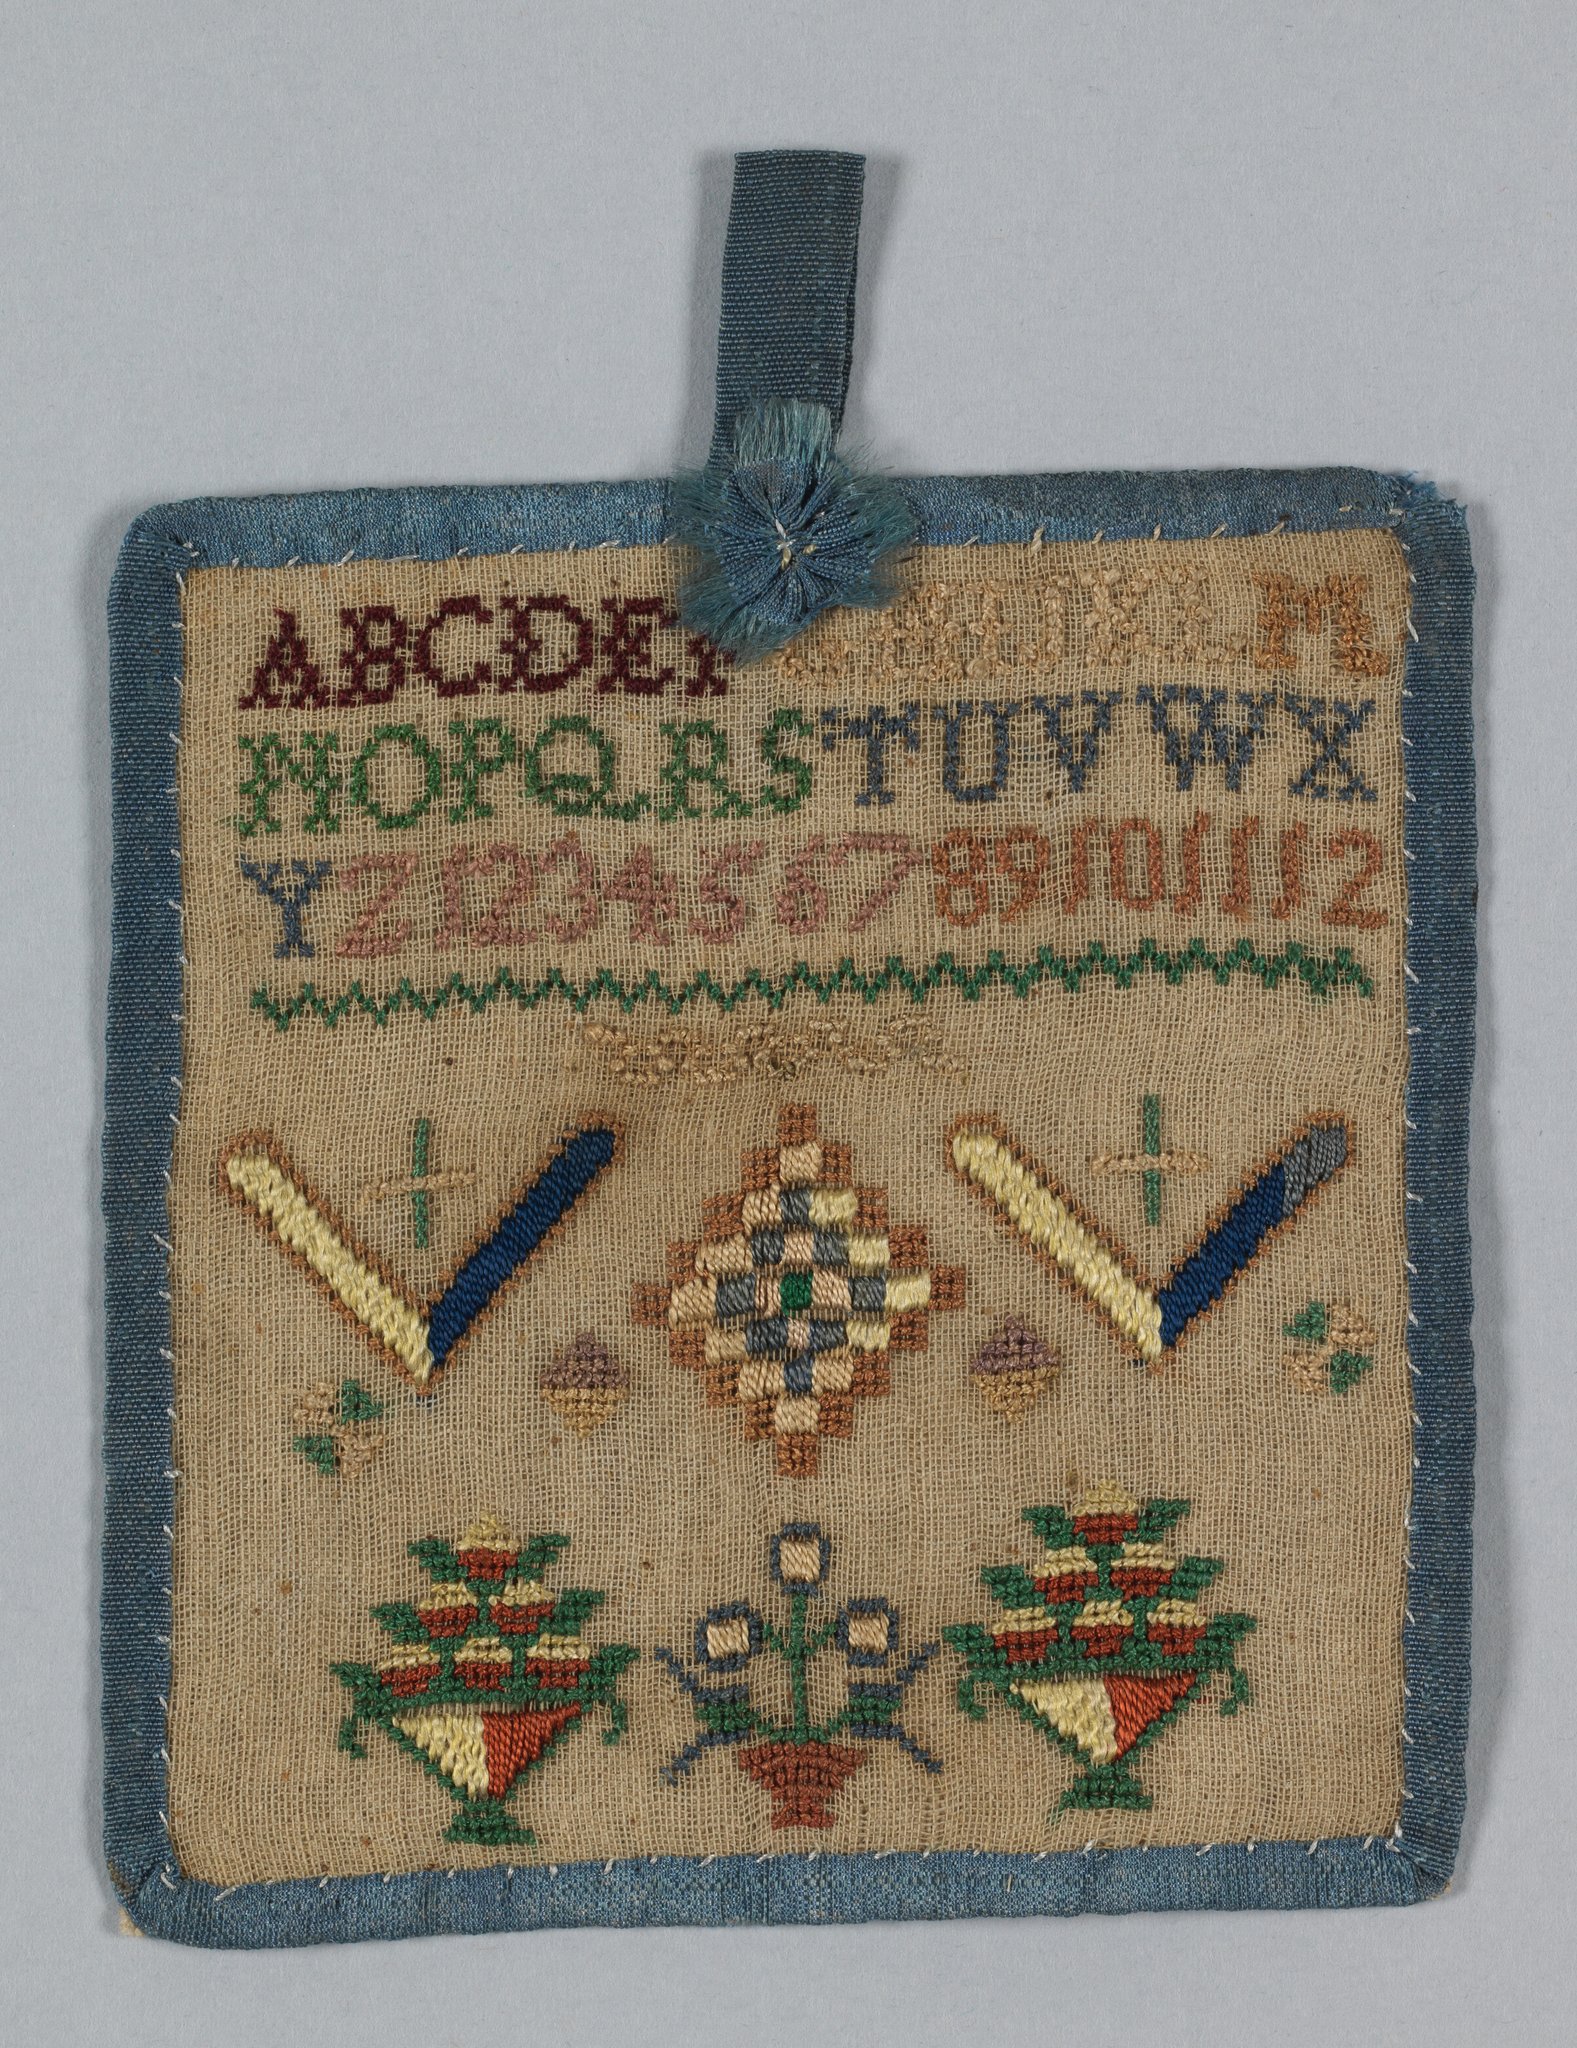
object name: sampler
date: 1801-1833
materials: canvas, silk